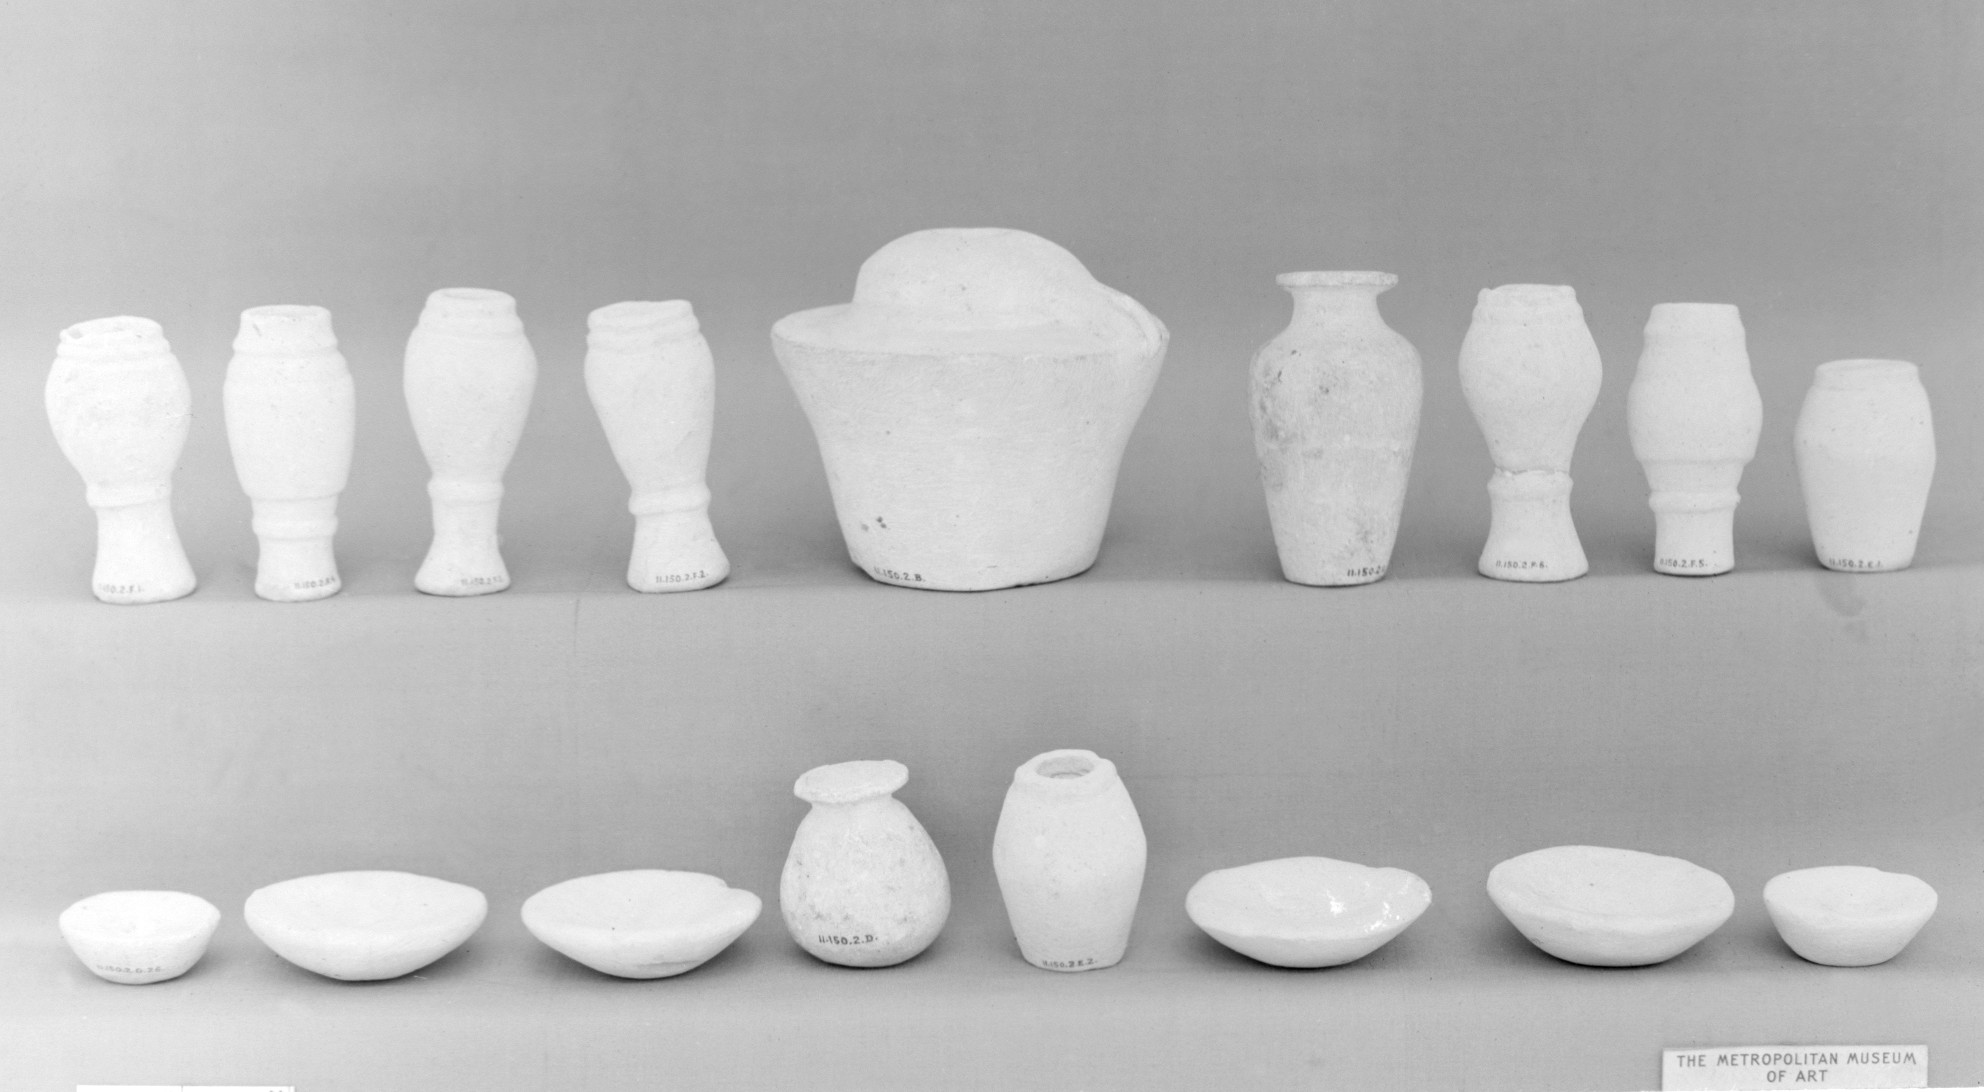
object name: ewer part of set of 71 object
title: Ewer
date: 2465-2150 BCE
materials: limestone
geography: memphite region